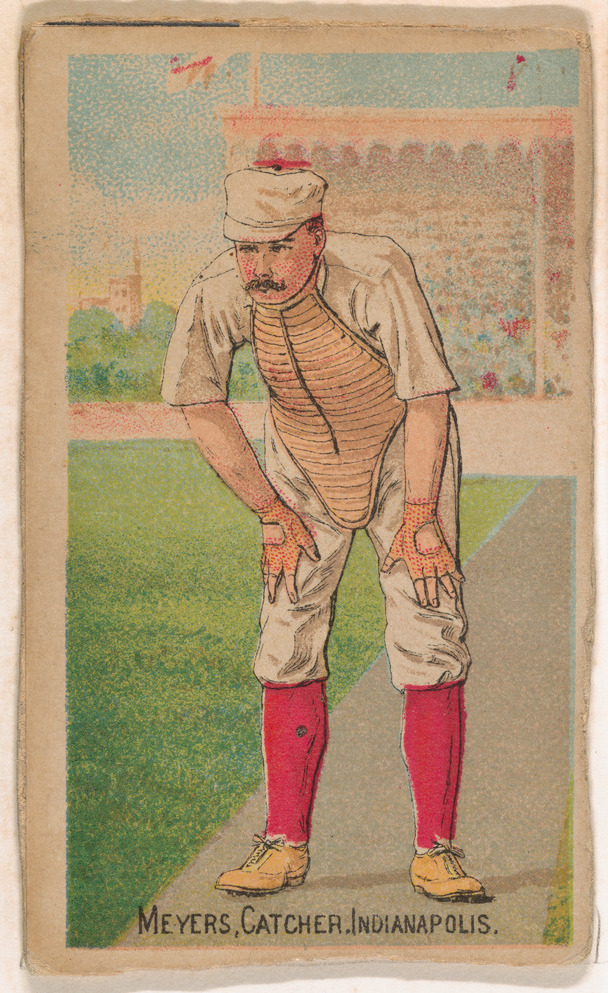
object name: baseball card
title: Meyers, Catcher, Indianapolis, from the Gold Coin series (N284) for Gold Coin Chewing Tobacco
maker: d. buchner & co., new york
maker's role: publisher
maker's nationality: american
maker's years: 1850-1900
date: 1887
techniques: color lithograph, drawing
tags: men,baseball,athletes